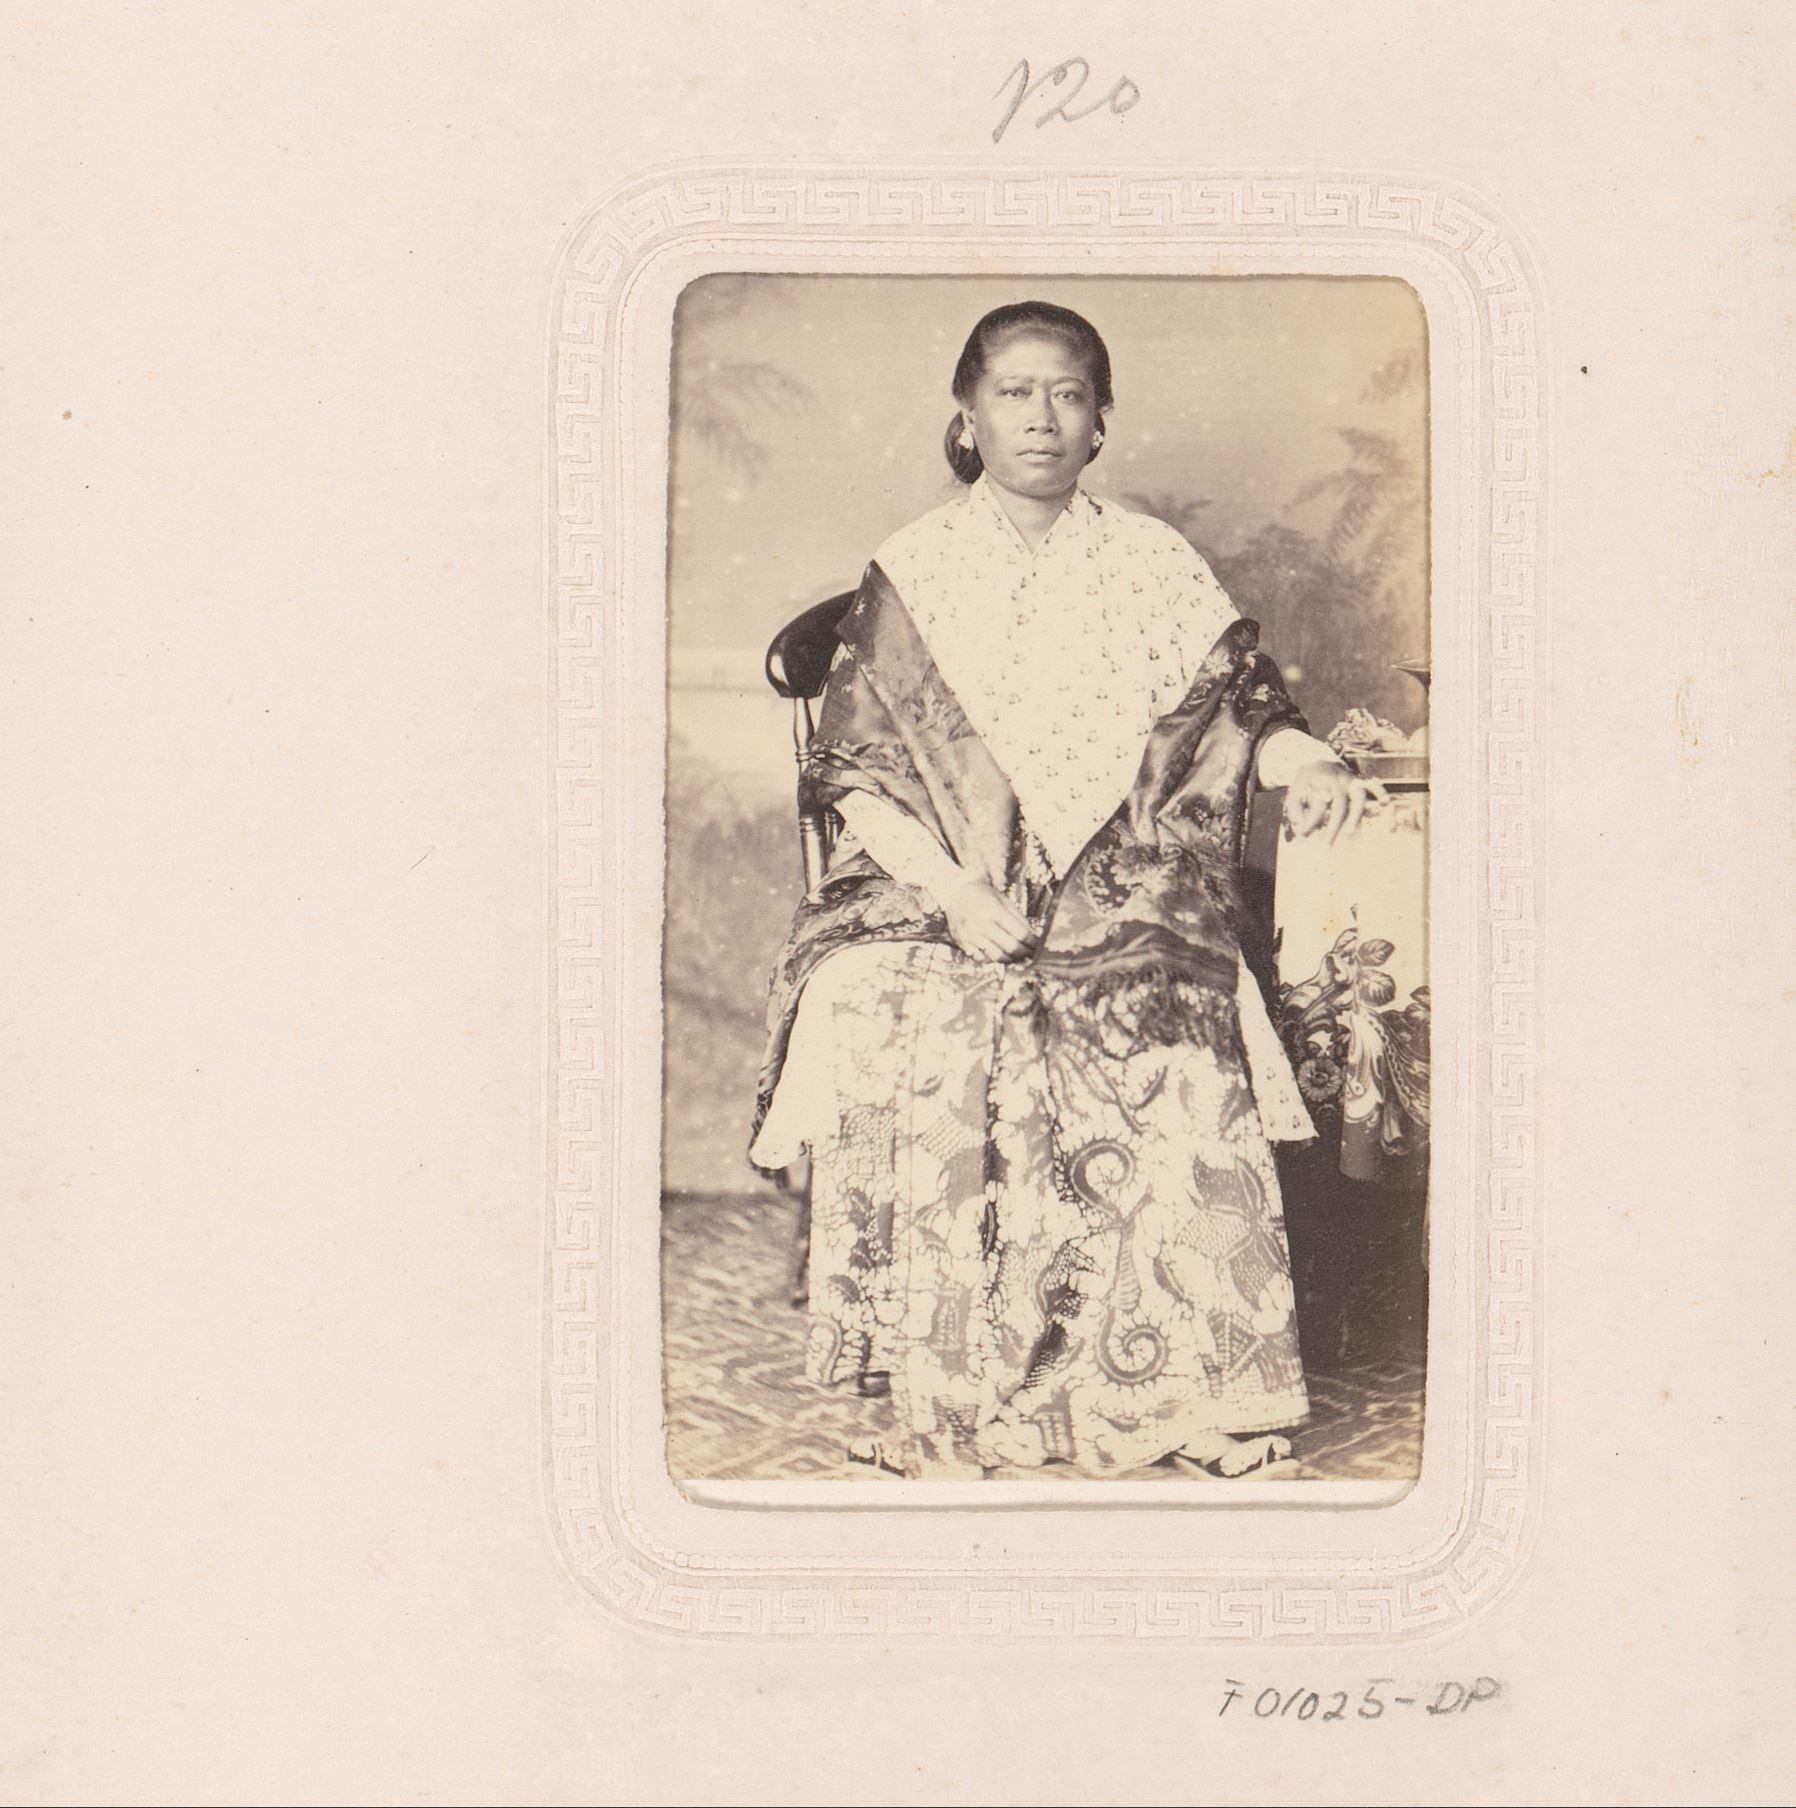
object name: photograph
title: Portret van een Indonesische vrouw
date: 1857-1880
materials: cardboard, photographic support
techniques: albumen print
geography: java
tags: historical persons - bb - woman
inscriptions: inscription: ‘Woodbury & Page/ Photographers/ Java’, number: ‘120’